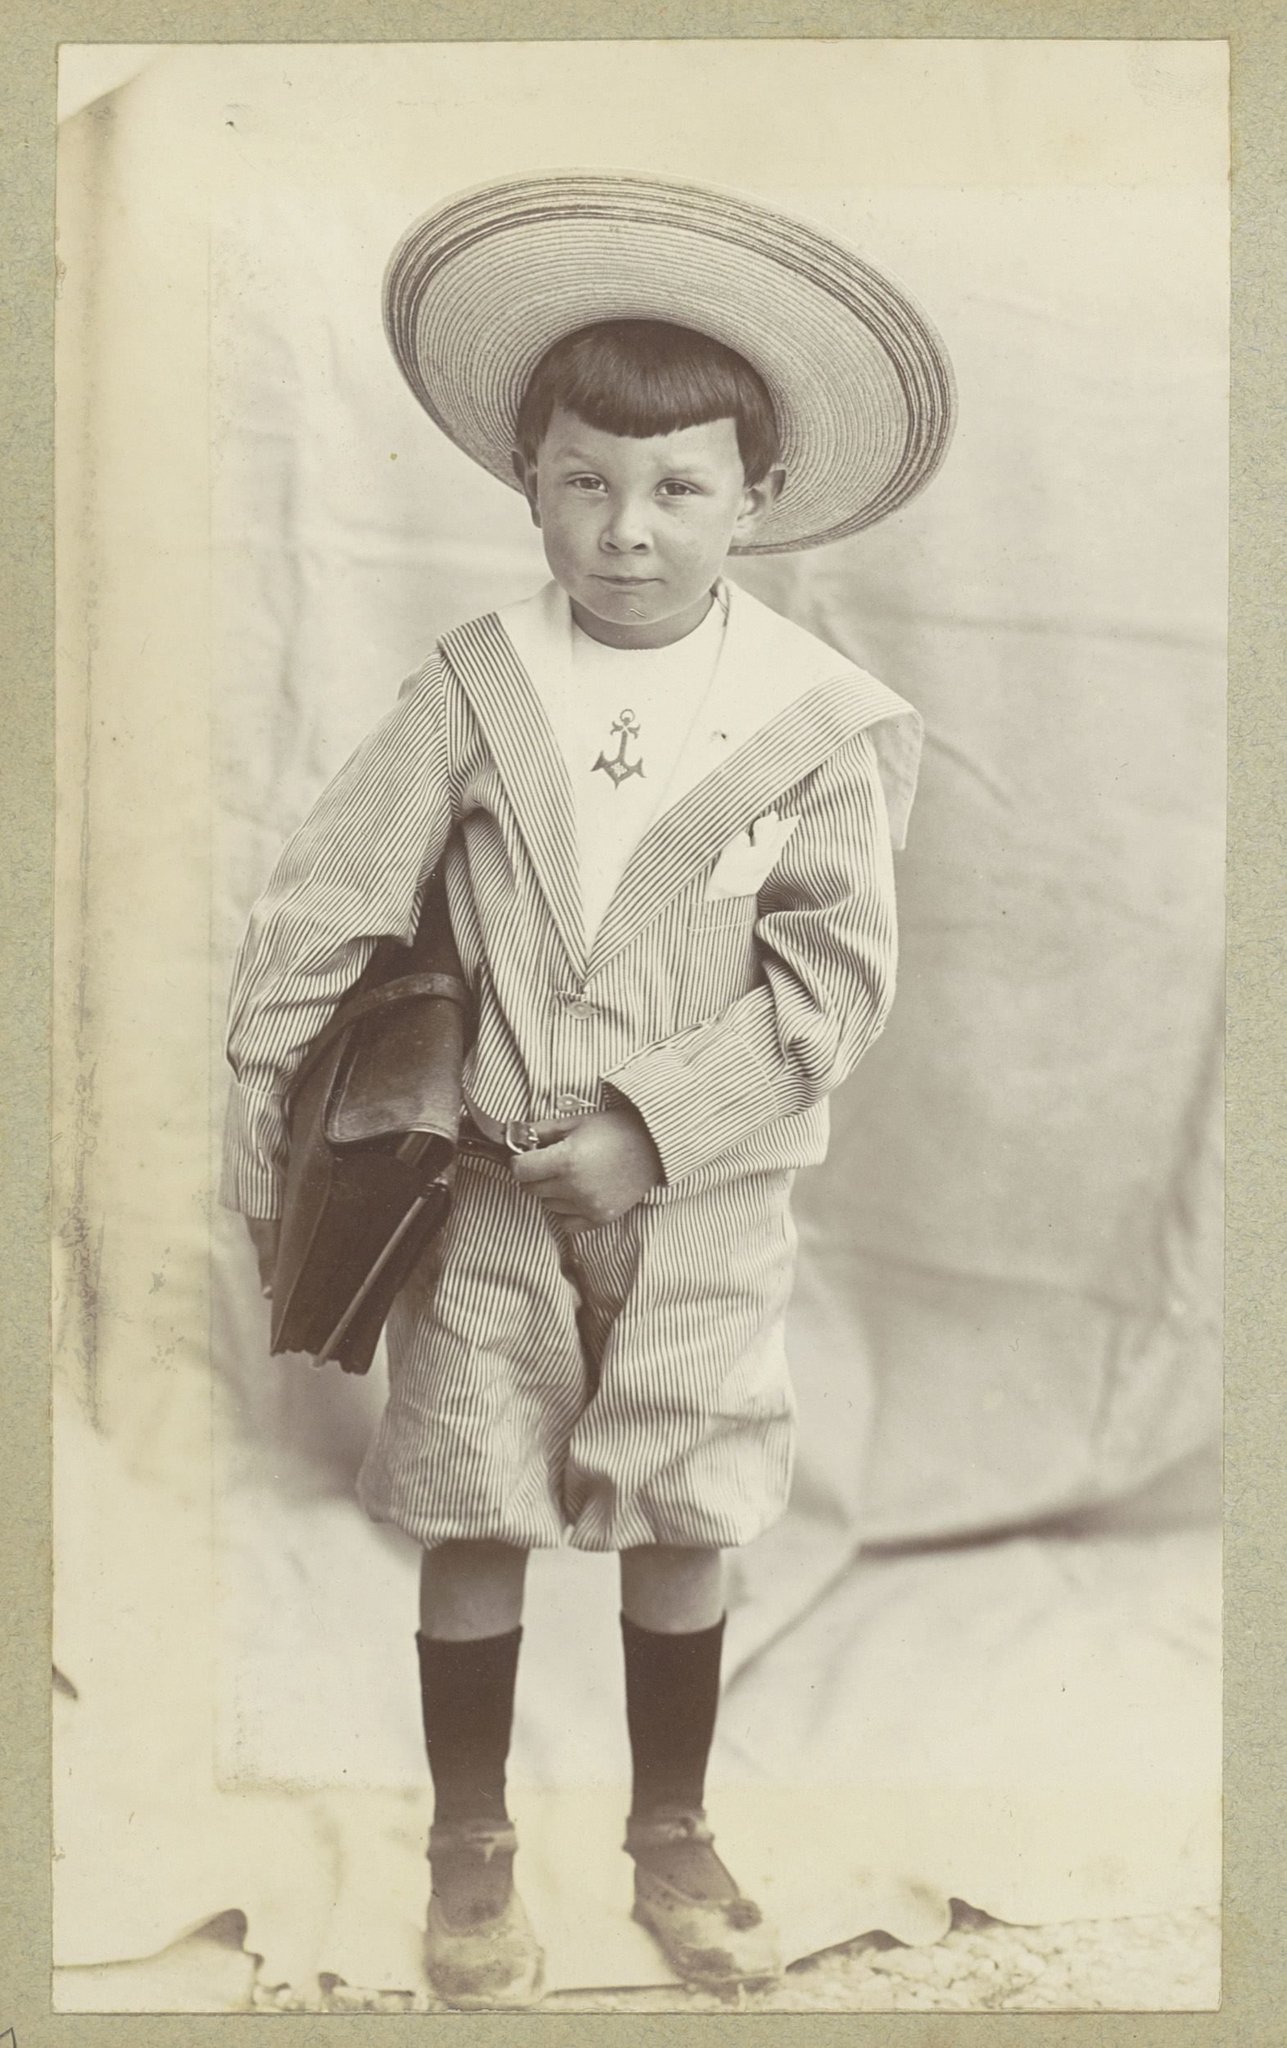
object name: photograph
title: Portret van een kind met een tas, een matrozenpakje en een zonnehoed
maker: Anonymous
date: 1885-1914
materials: photographic support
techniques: gelatin silver print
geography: france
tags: france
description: Onderdeel van Fotoalbum met familiefoto's.